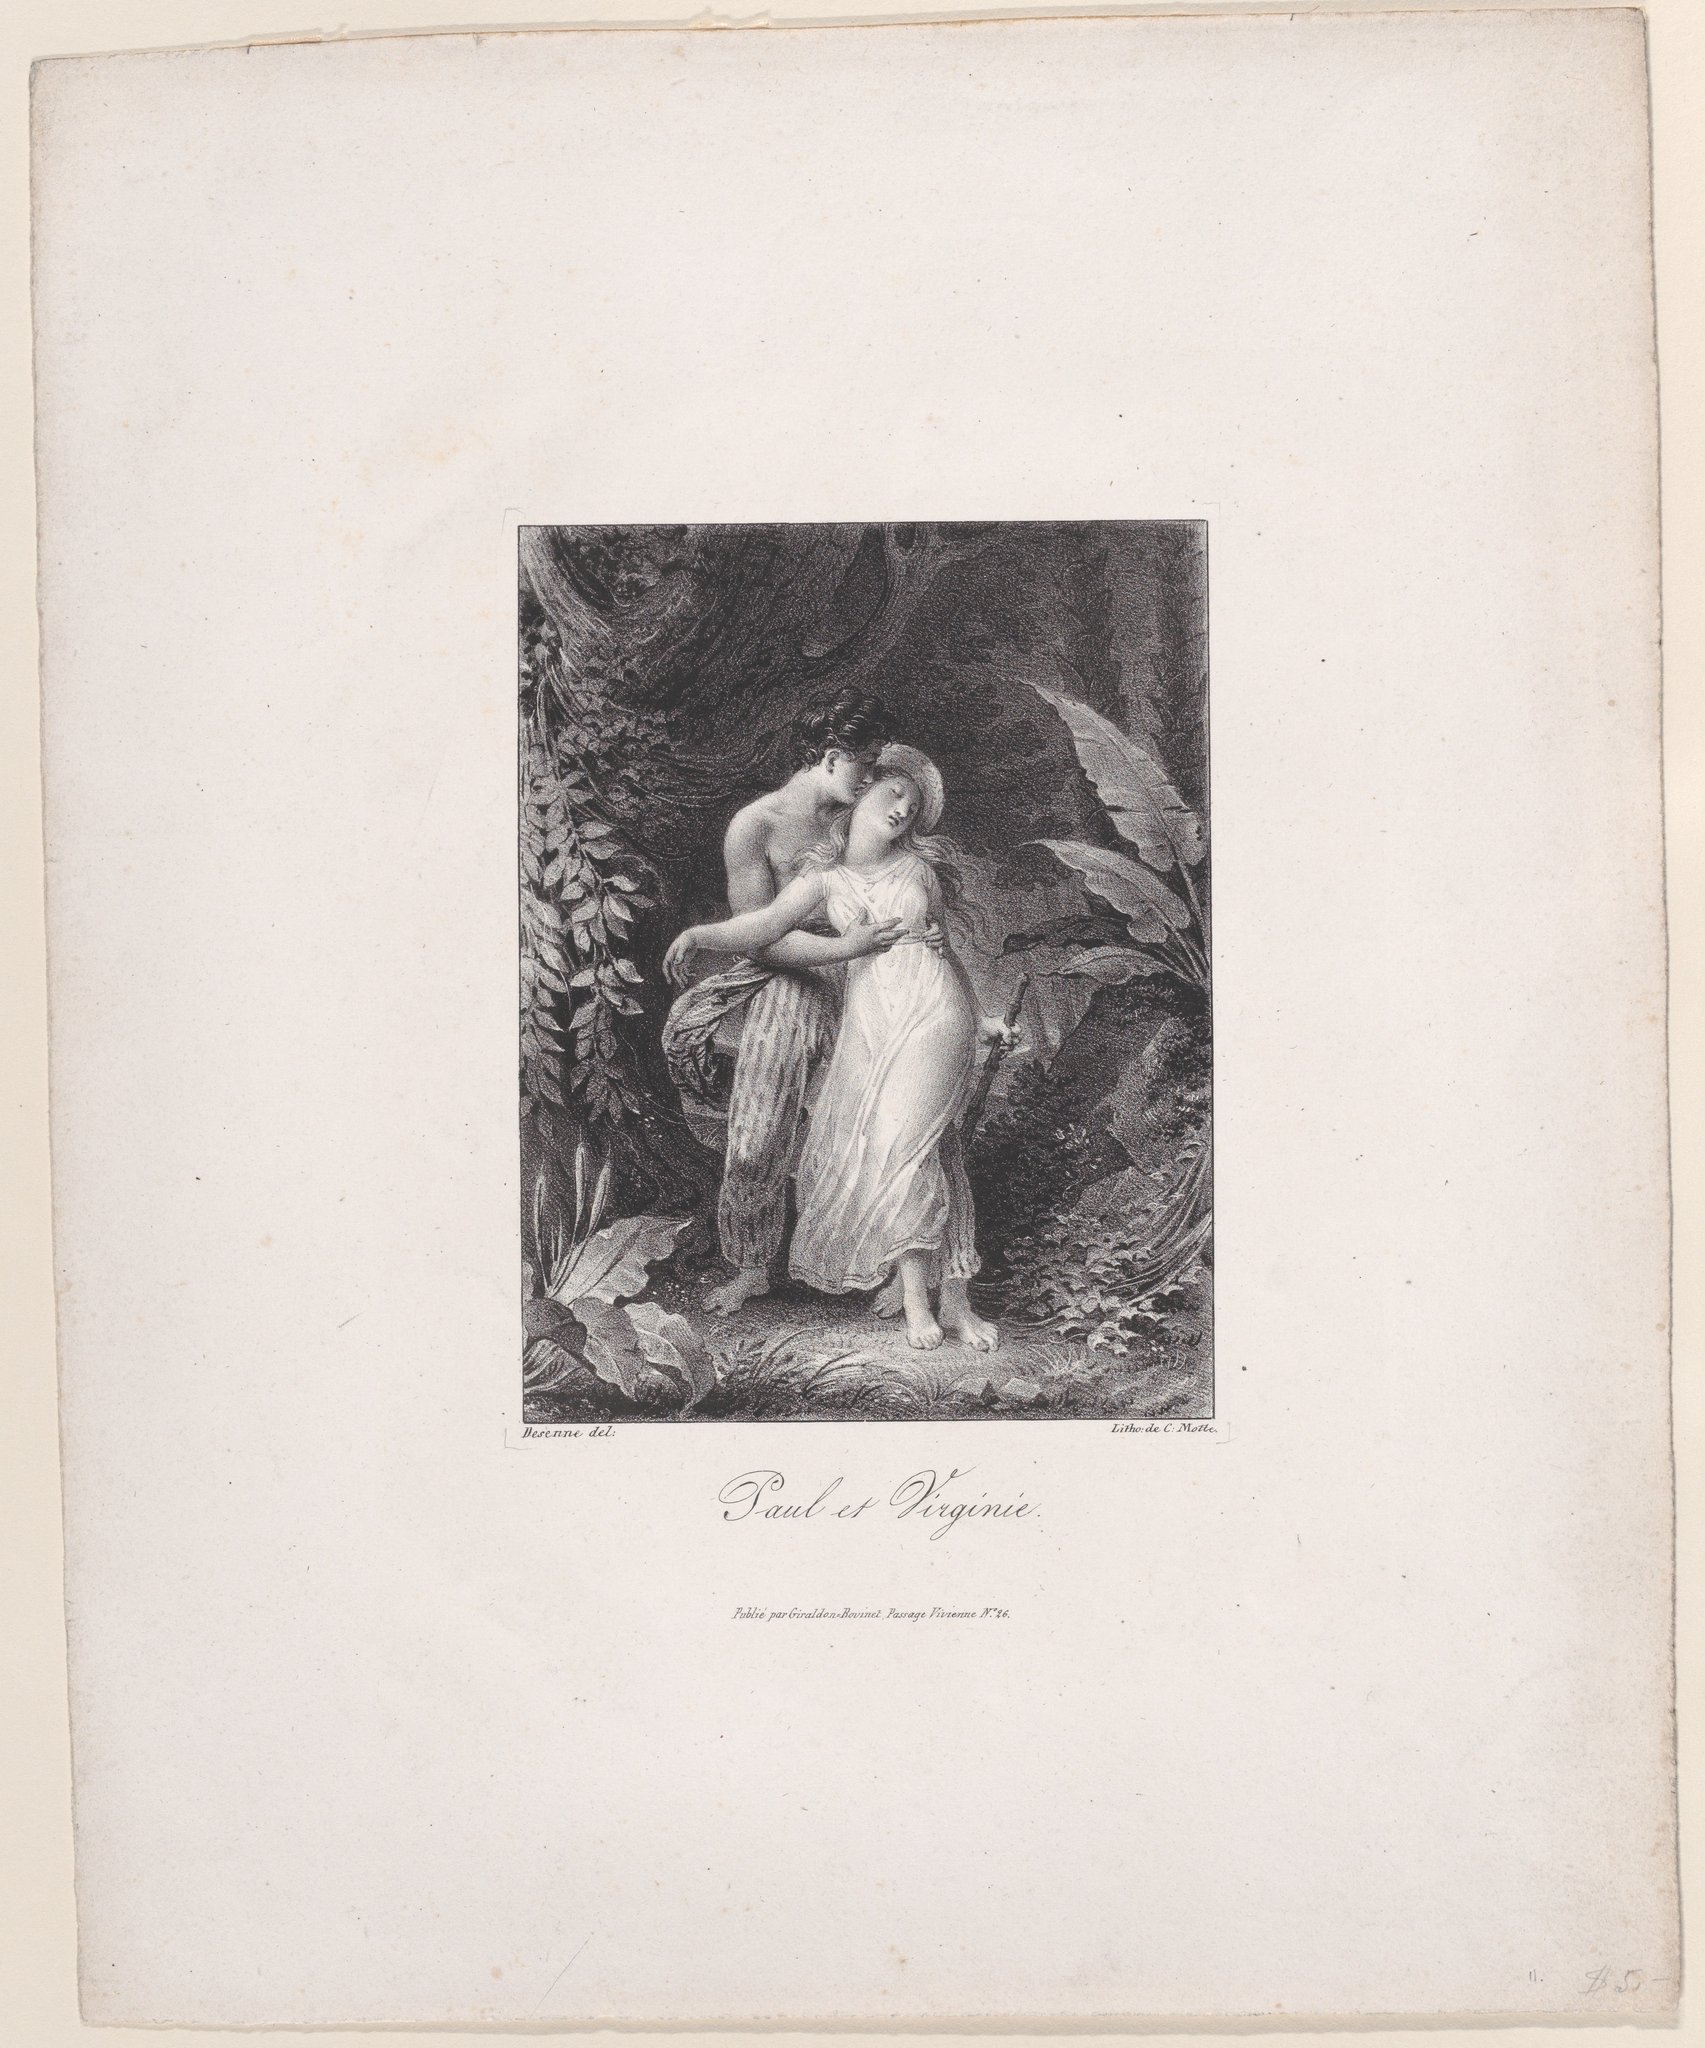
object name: print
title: Paul and Virginia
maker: alexandre joseph desenne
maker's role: artist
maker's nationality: french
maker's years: 1785-1827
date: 1805-1827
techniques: lithograph